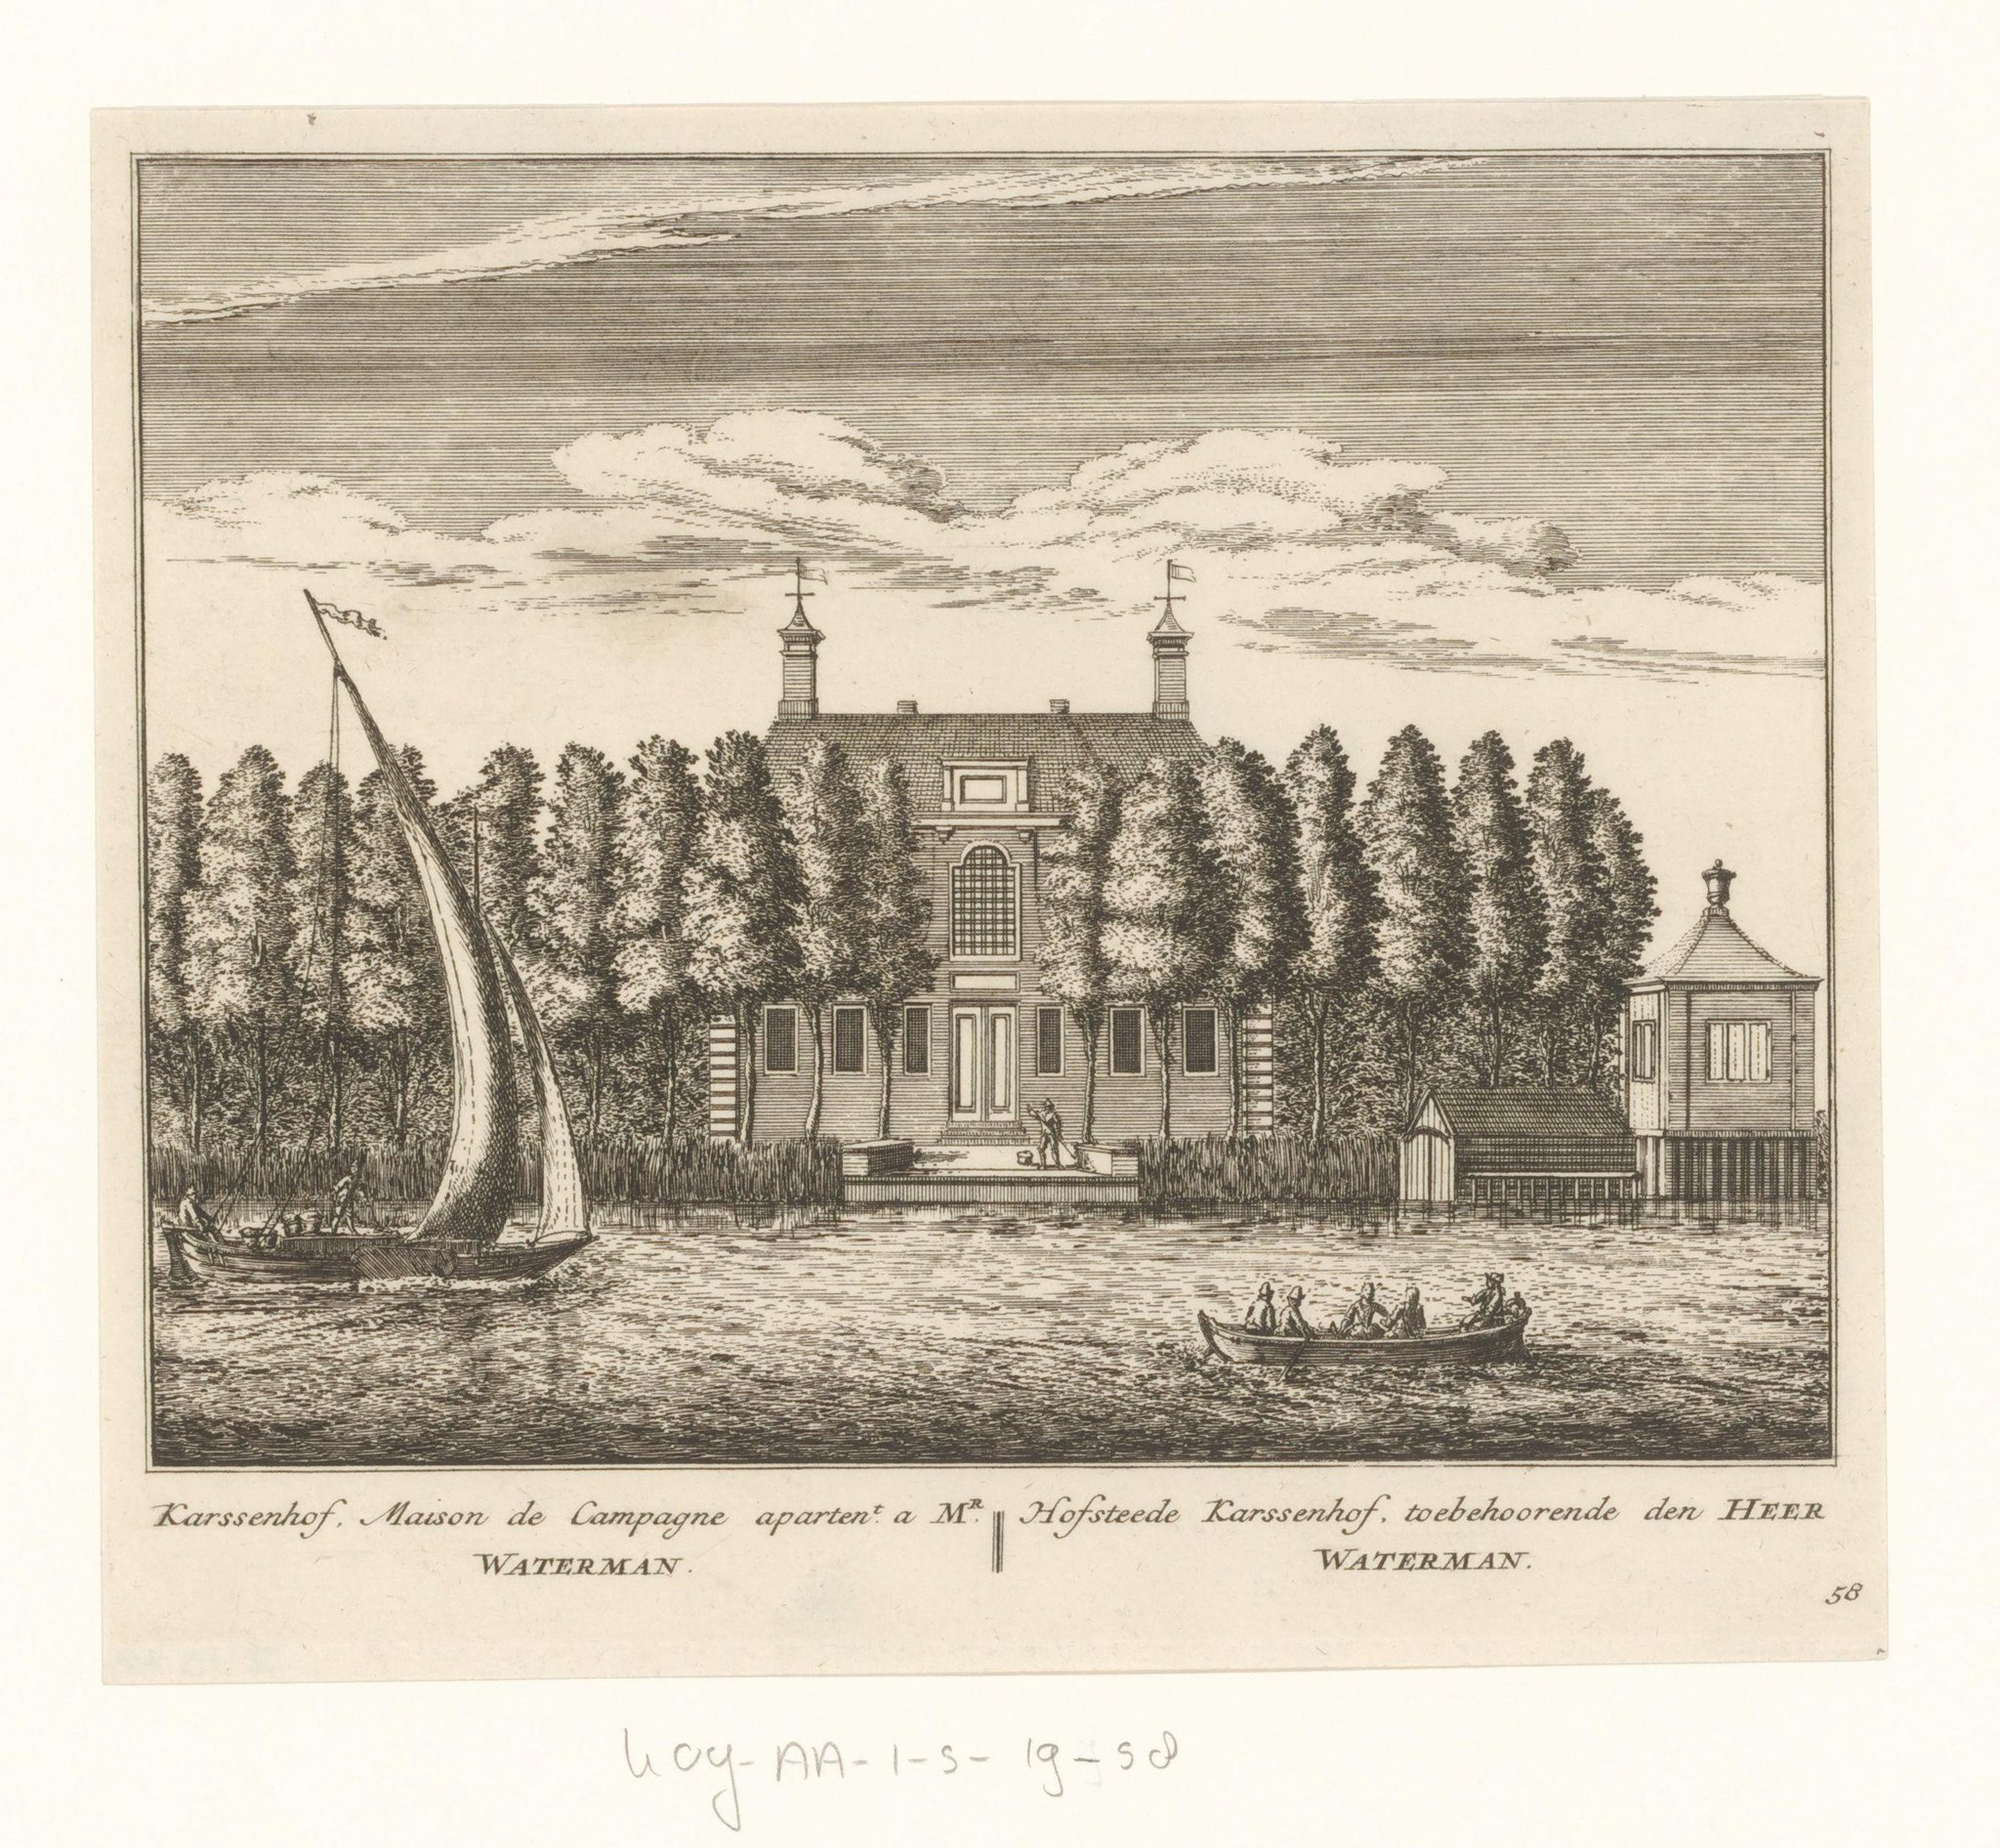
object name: print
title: Gezicht op buitenplaats Karssenhof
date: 1730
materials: paper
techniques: etching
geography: amsterdam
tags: sailing-ship, sailing-boat, city-view in general; 'veduta', river, rural housing, e.g. country-house, villa, cottage, boat propelled by man or animal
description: Prent waarschijnlijk uit: Tijsens, Gijsbert. Hollands Arcadia, of de vermaarde rivier den Amstel (...) naar 't léven getekend en in 't ligt gebragt door Abraham Rademaker (...). Amsterdam: Leonardus Schenk, 1730.